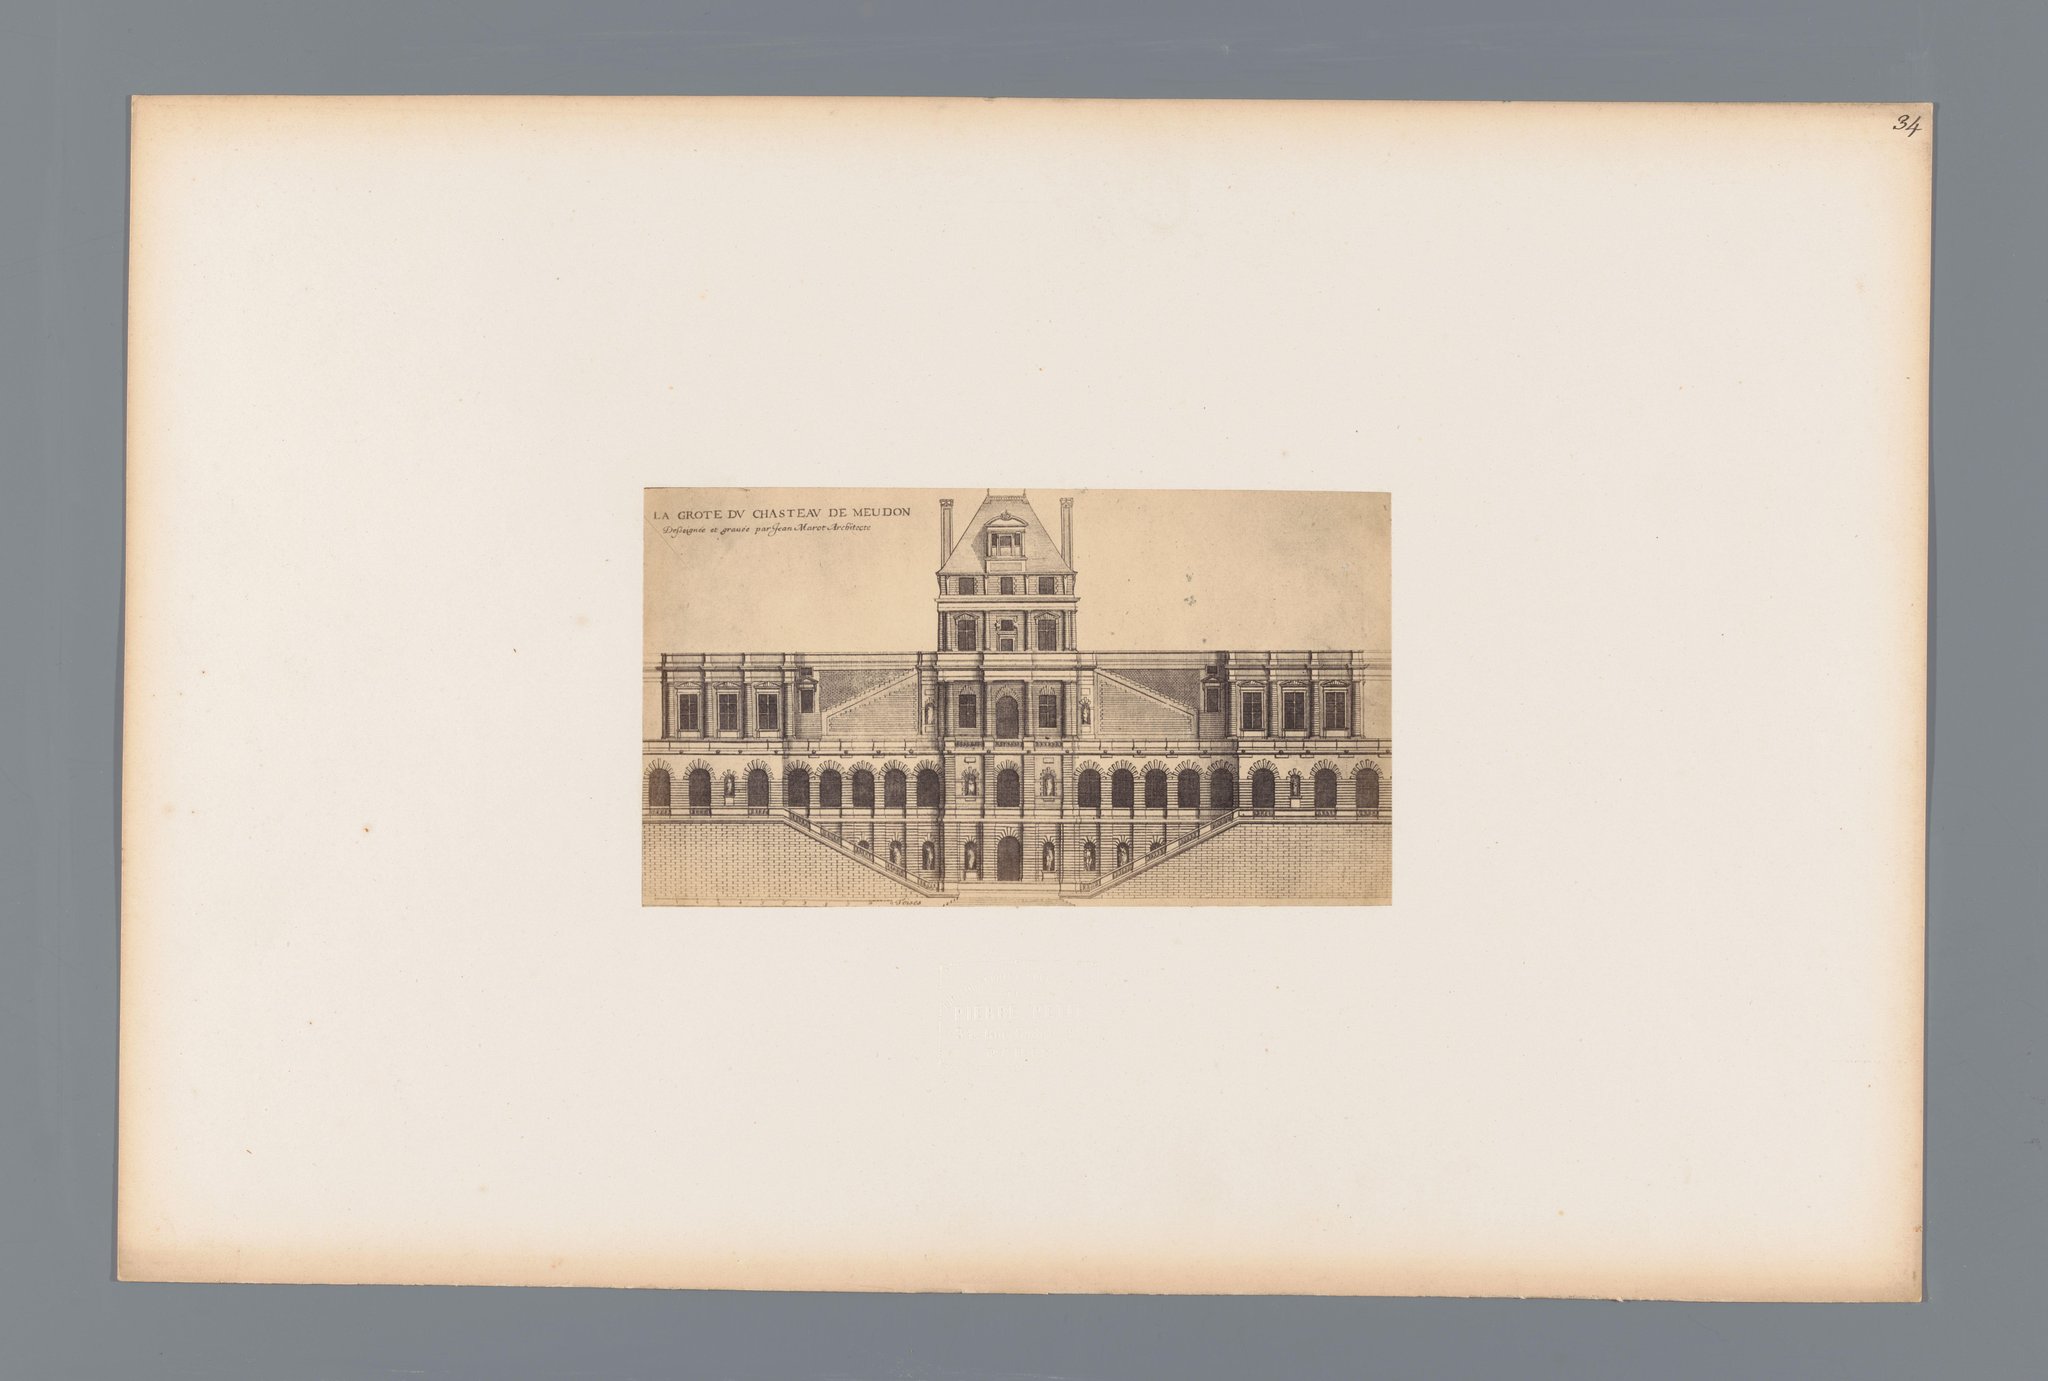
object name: photograph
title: Fotoreproductie van een ontwerp van de grot van het kasteel van Meudon door Jean Marot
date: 1860-1865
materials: photographic support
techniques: albumen print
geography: paris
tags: castle, cave, grotto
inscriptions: check stamp: ‘PHOTOGRAPHIE des DEUX MONDES/ PIERRE PETIT/ 31, Rue Cadet, 31/ PARIS’, number: ‘34’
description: Deze foto maakt deel uit van een omslag met 38 foto's en 17 tekstbladen.